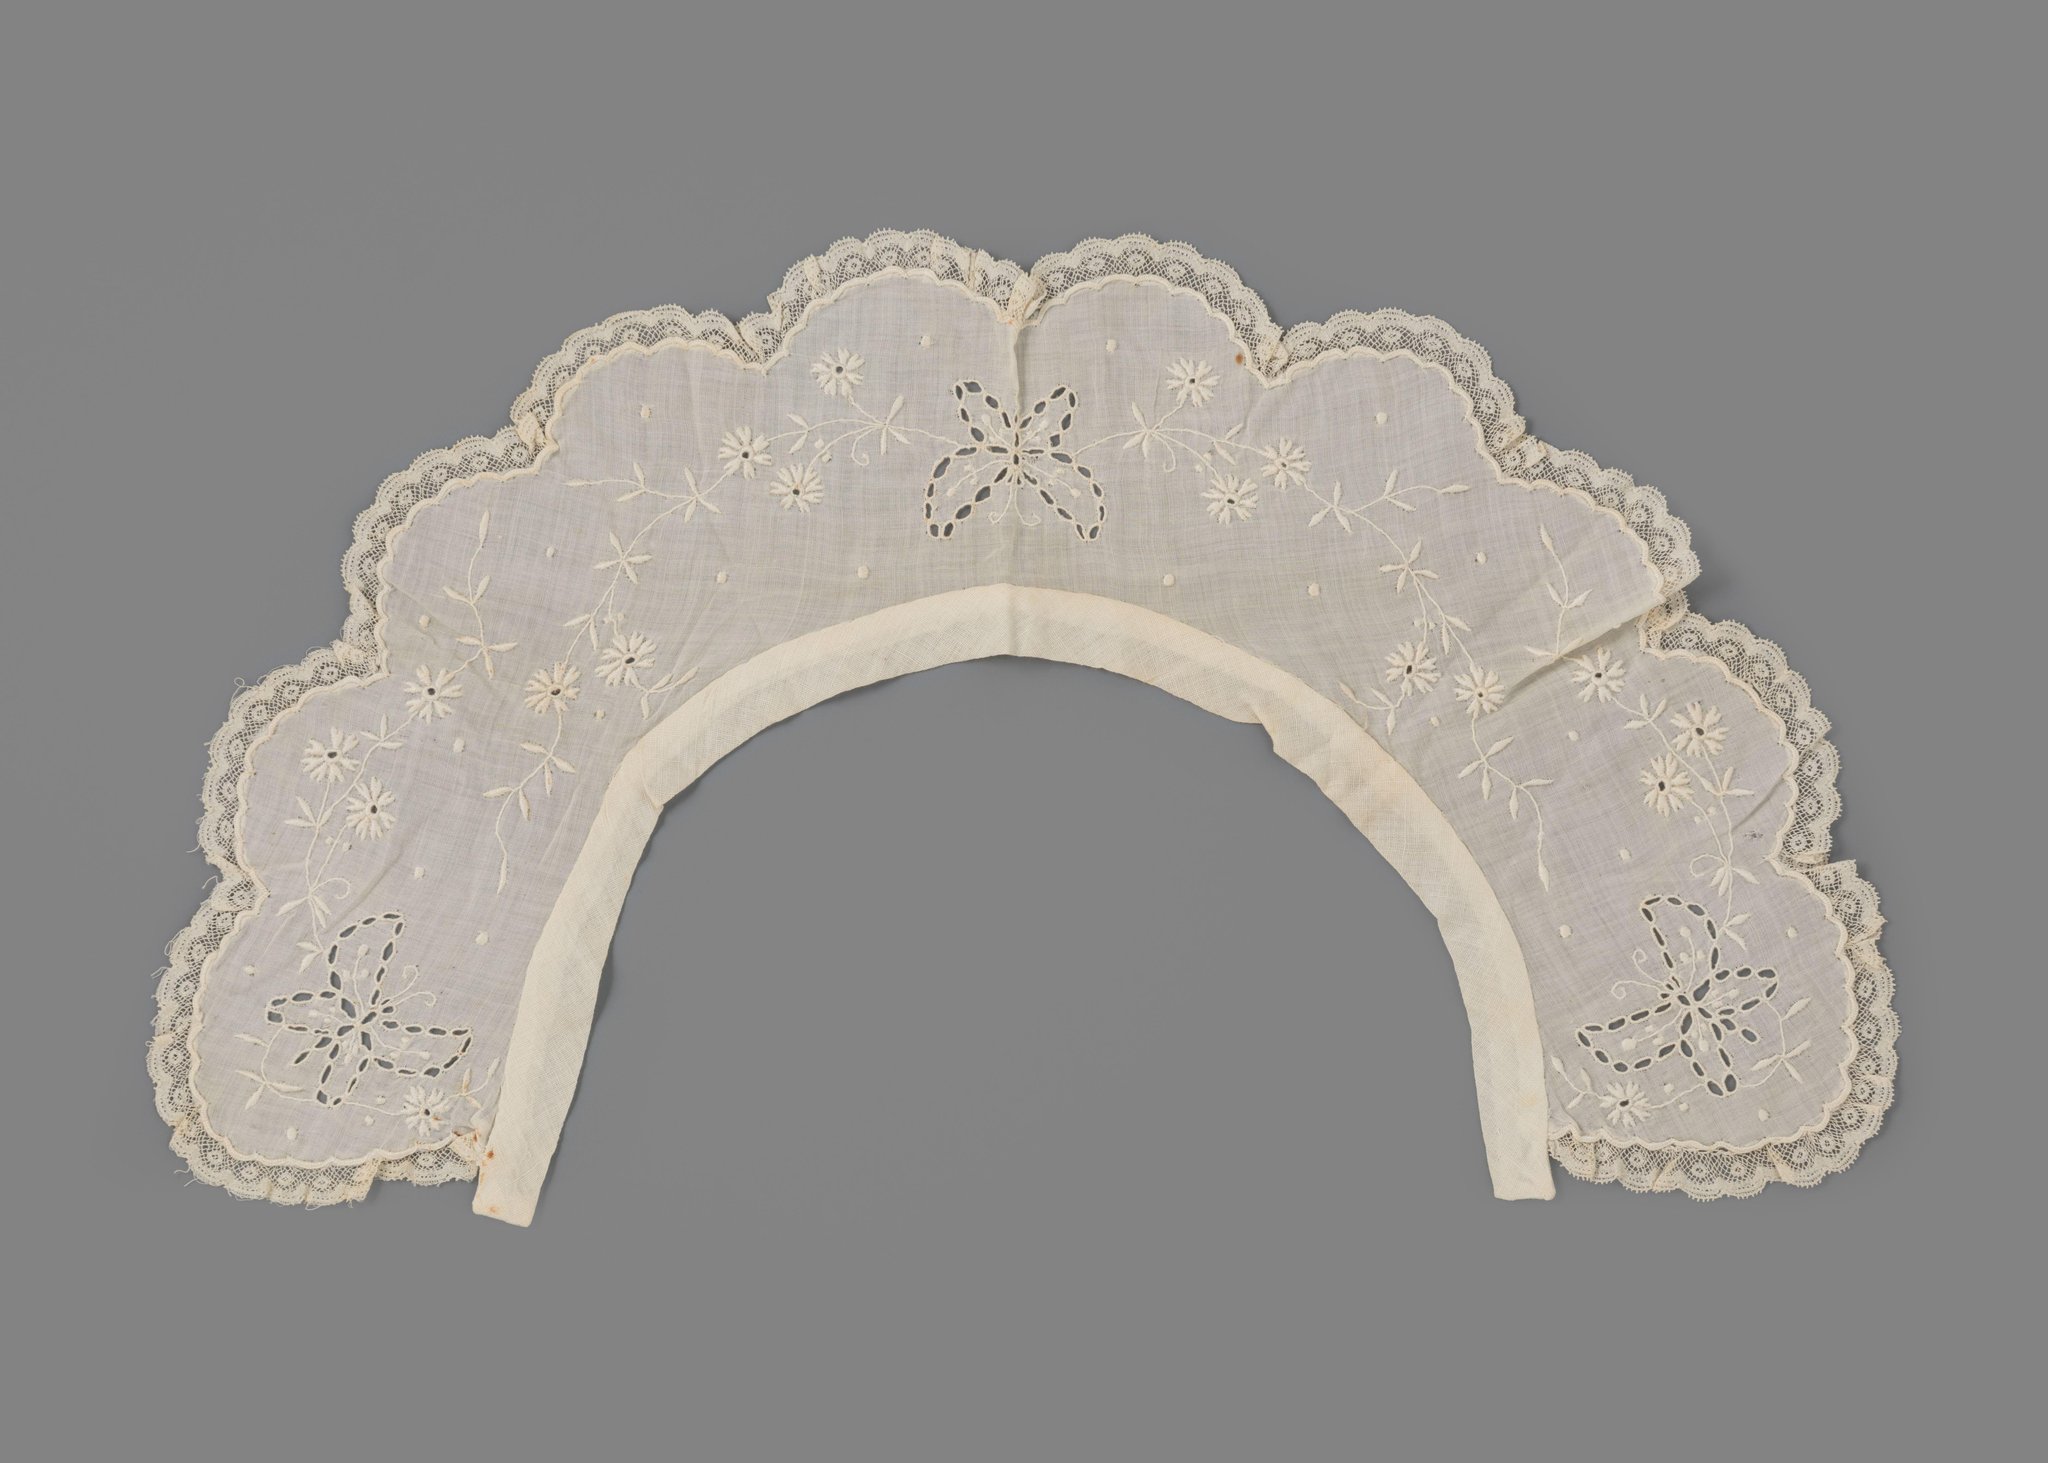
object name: collar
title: Kraag, geschulpt, van geborduurd batist met rand Valenciennes-kant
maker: Anonymous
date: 1930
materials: linen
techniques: embroidered, lace, embroidery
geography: netherlands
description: Kraag, geschulpt, van geborduurd batist met rand Valenciennes-kant, rond en liggend model. De rand bestaat uit tien schulpen die ook weer zijn geschulpt. Het patroon bestaat uit drie opengewerkte vlinders, waartussen een ranken met korenbloemen.